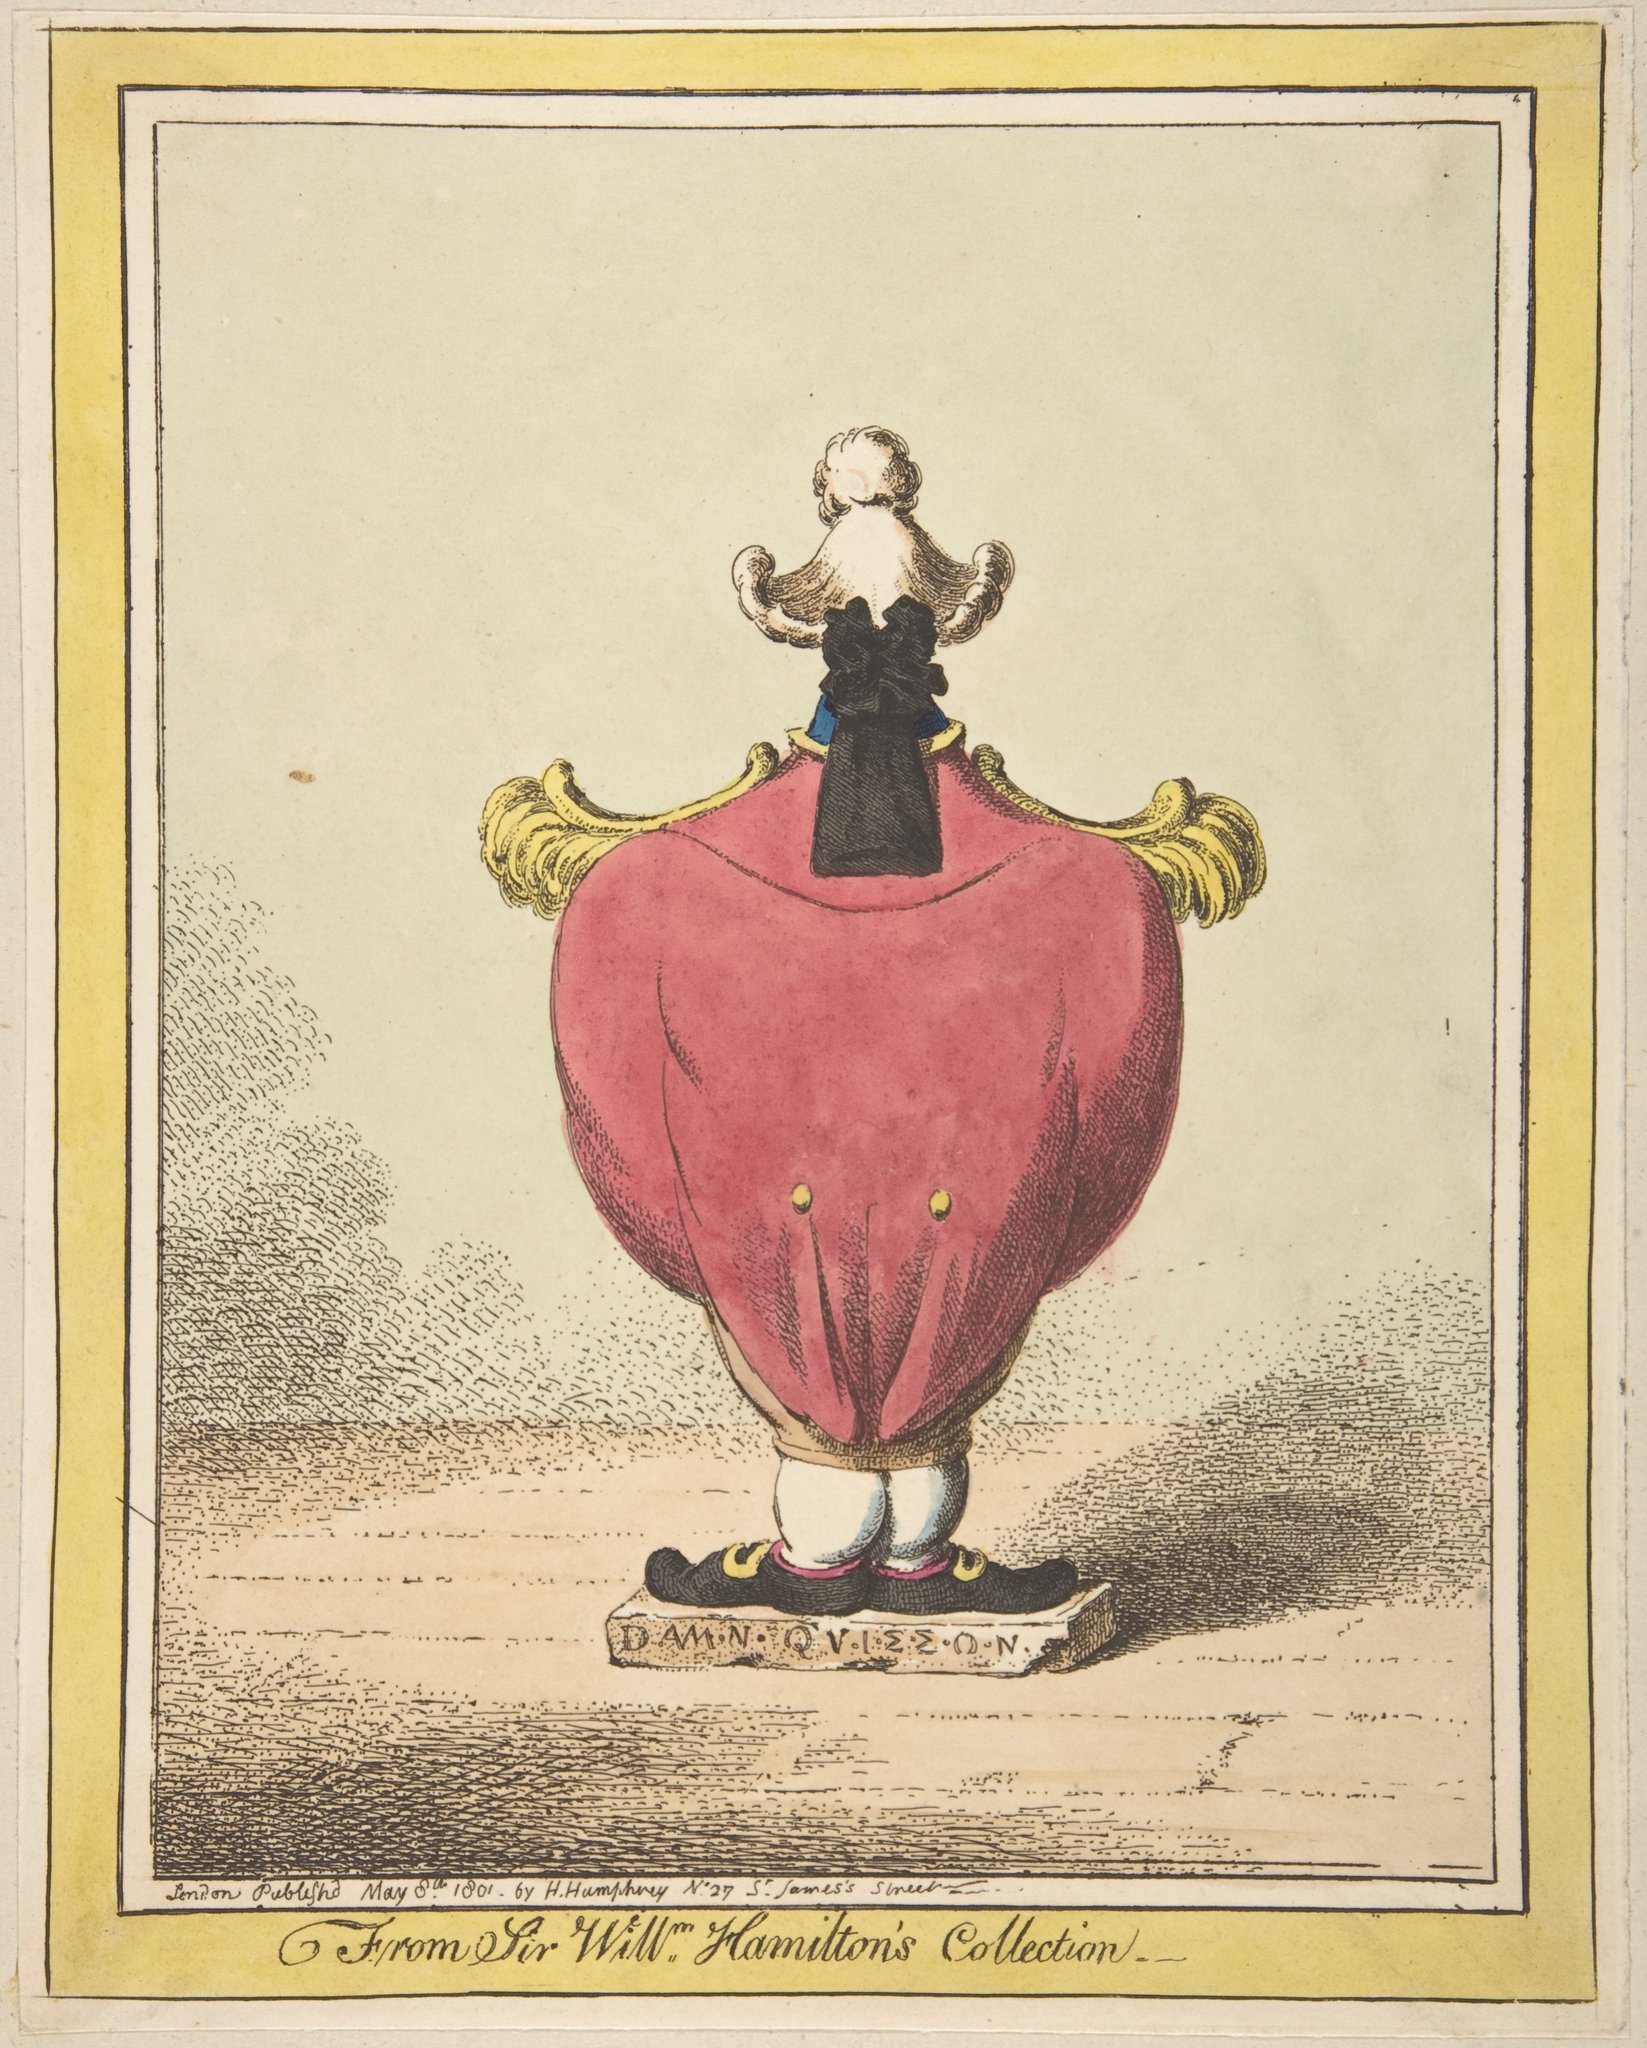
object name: print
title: From Sir William Hamilton's Collection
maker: james gillray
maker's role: artist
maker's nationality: british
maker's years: 1756-1815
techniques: etching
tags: men